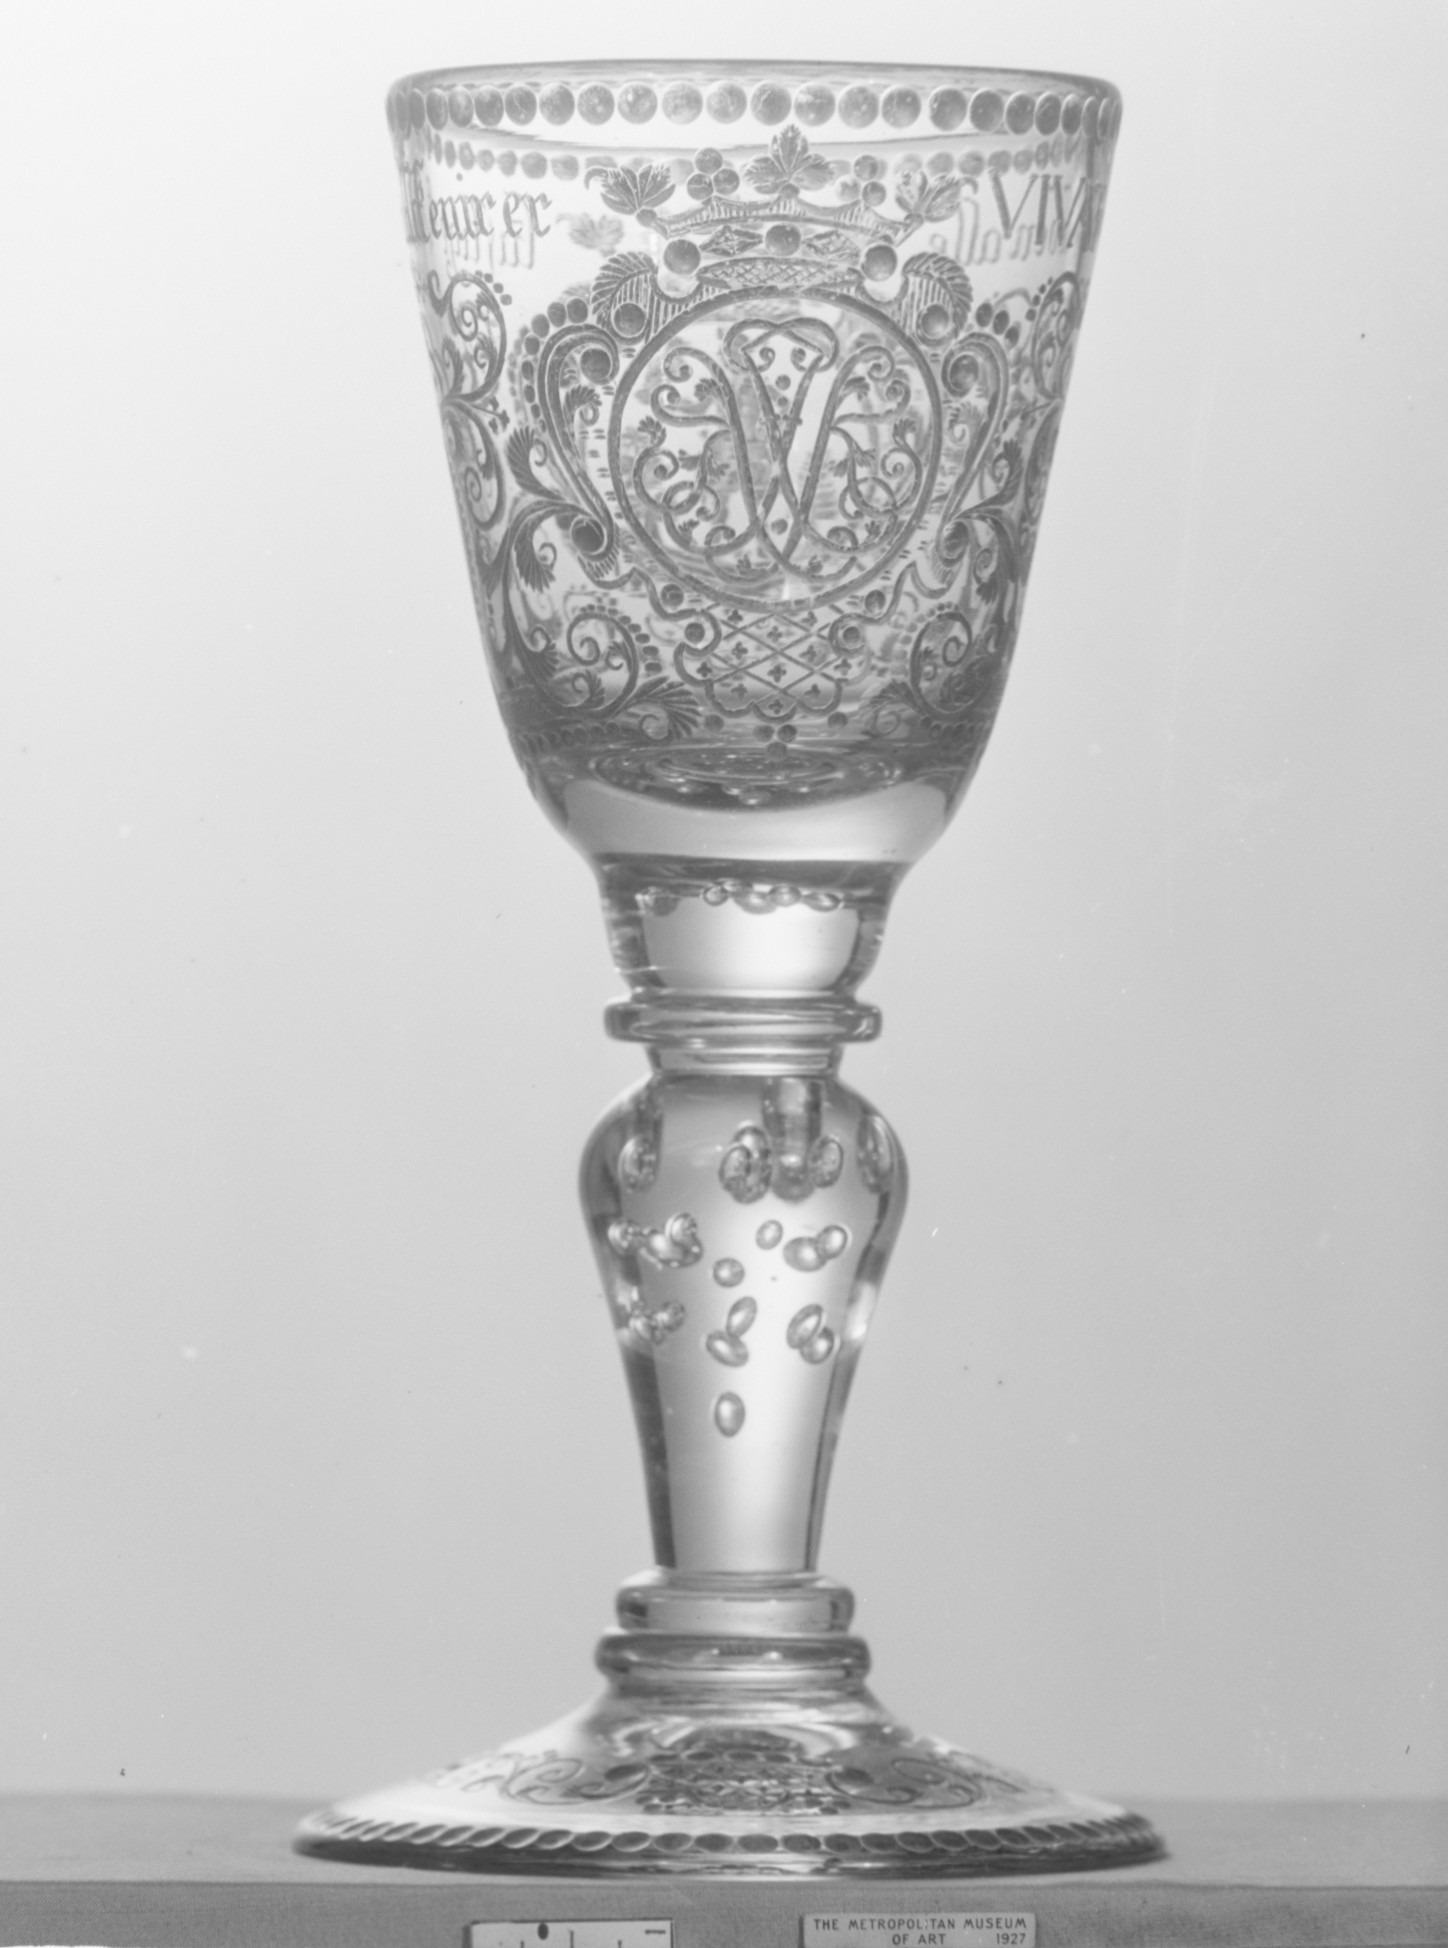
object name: standing cup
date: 1700-1750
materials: glass